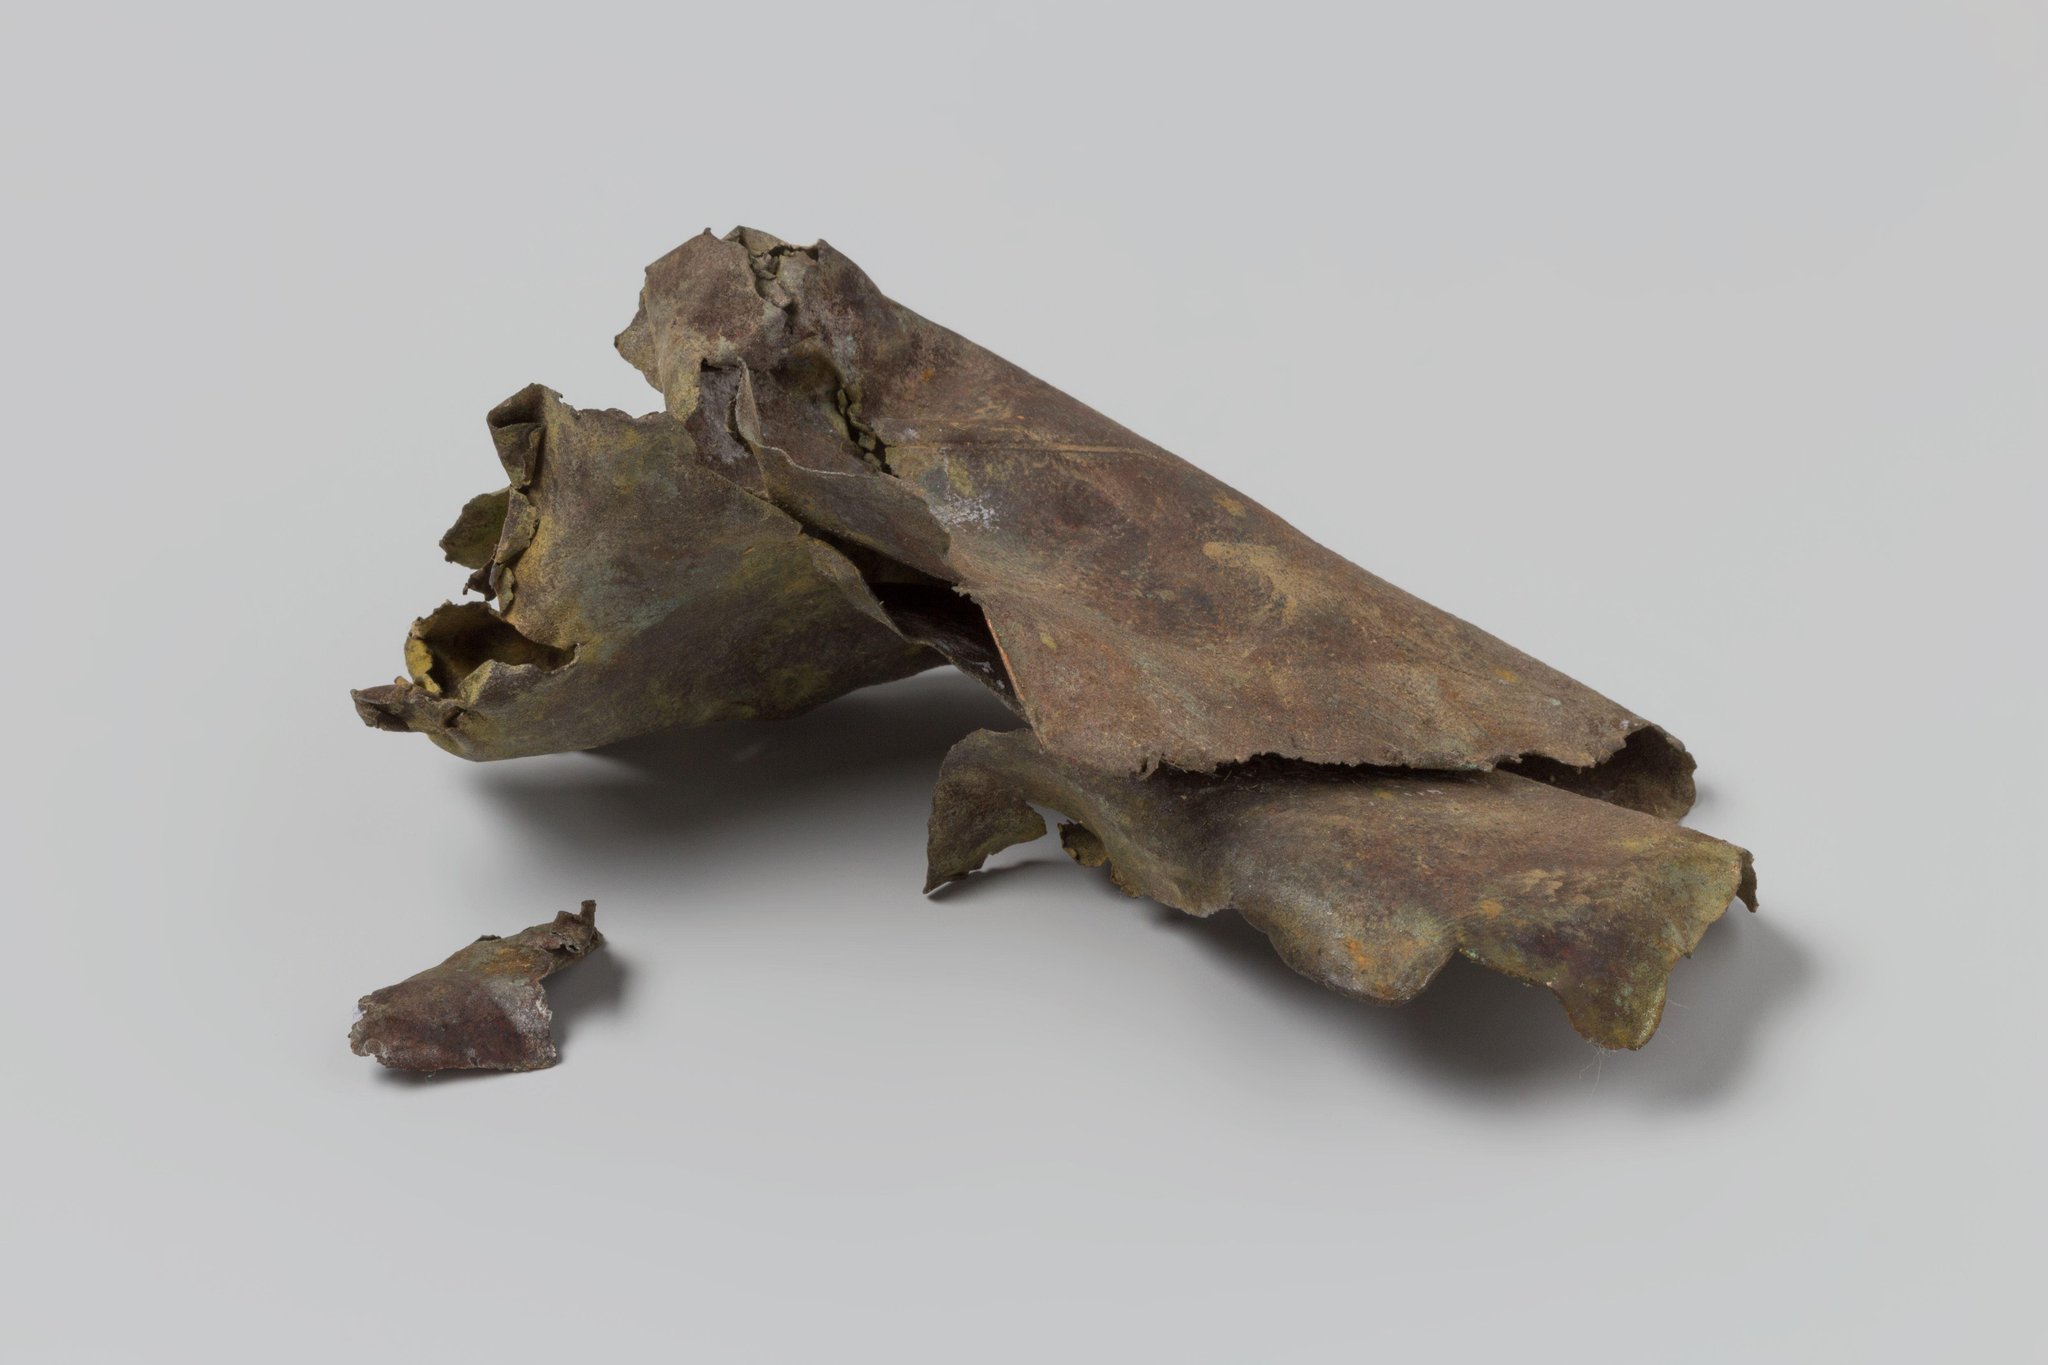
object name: scheepswrakvondst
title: Fragmenten van koper uit het wrak van de Oost-Indiëvaarder Hollandia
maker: Anonymous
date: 1700-1743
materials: copper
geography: netherlands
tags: verenigde oostindische compagnie, hollandia (schip), annet